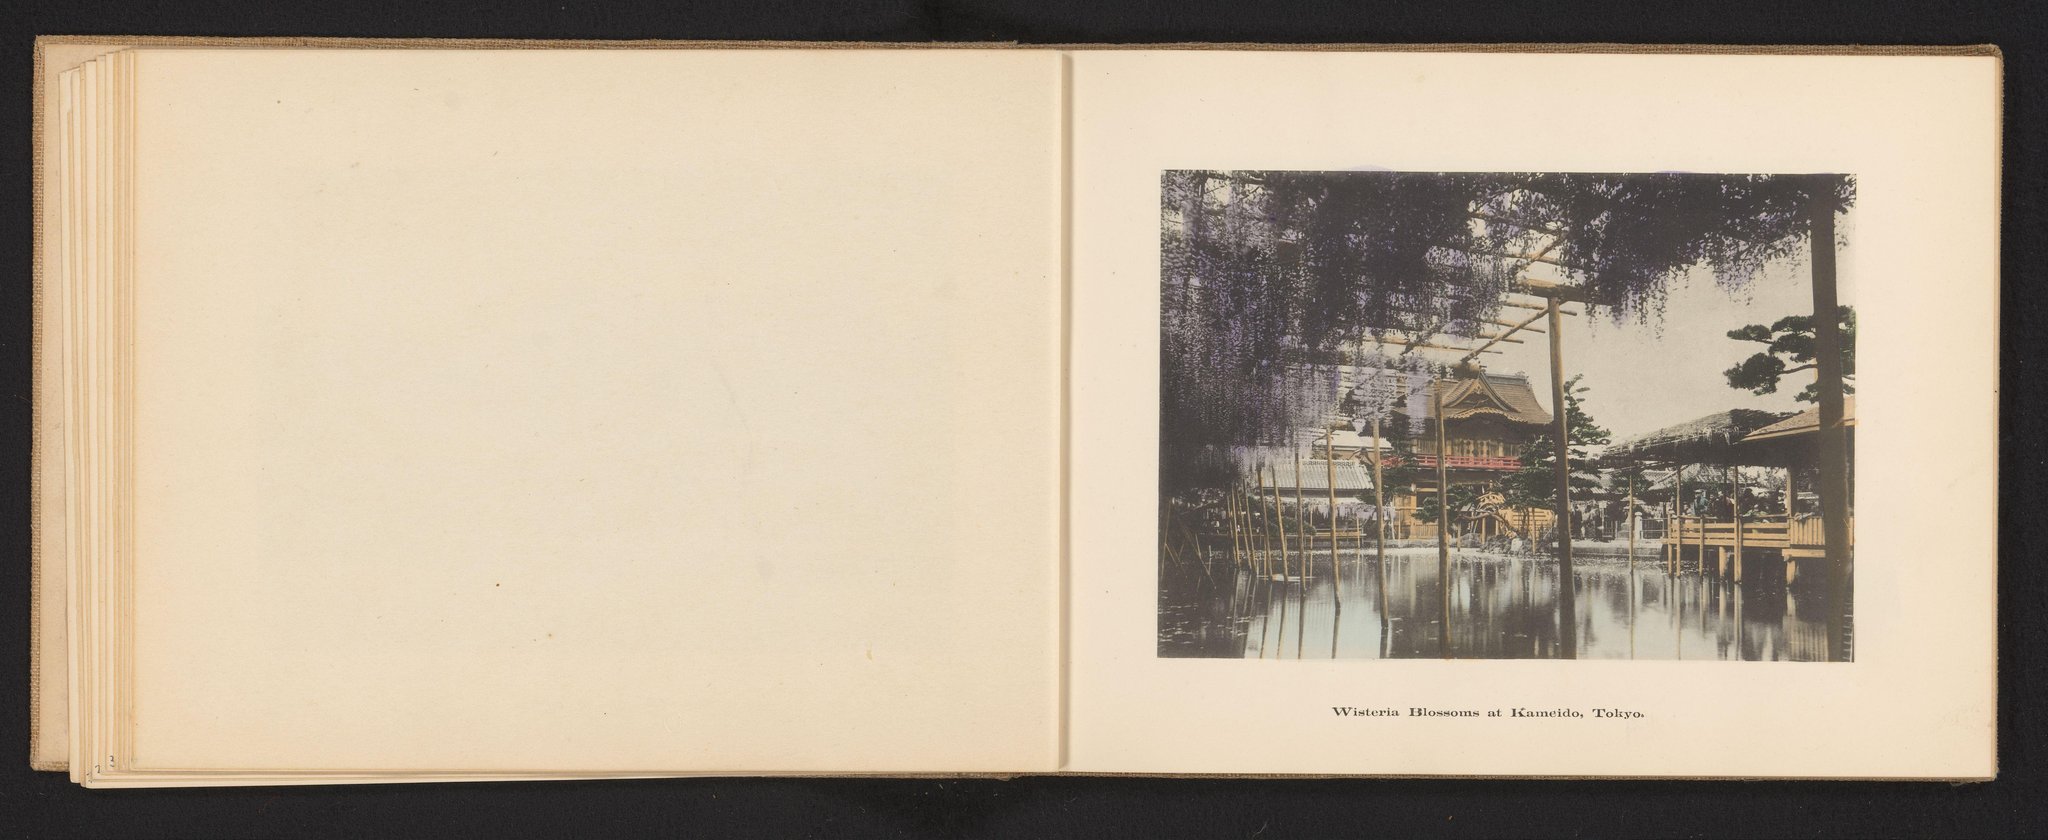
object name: page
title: Wisteria Blossoms at Kameido, Tokyo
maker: kōzaburō tamamura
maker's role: fotograaf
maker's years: 1856-1923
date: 1895-1905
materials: paper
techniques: photograph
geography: tokyo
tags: flowers